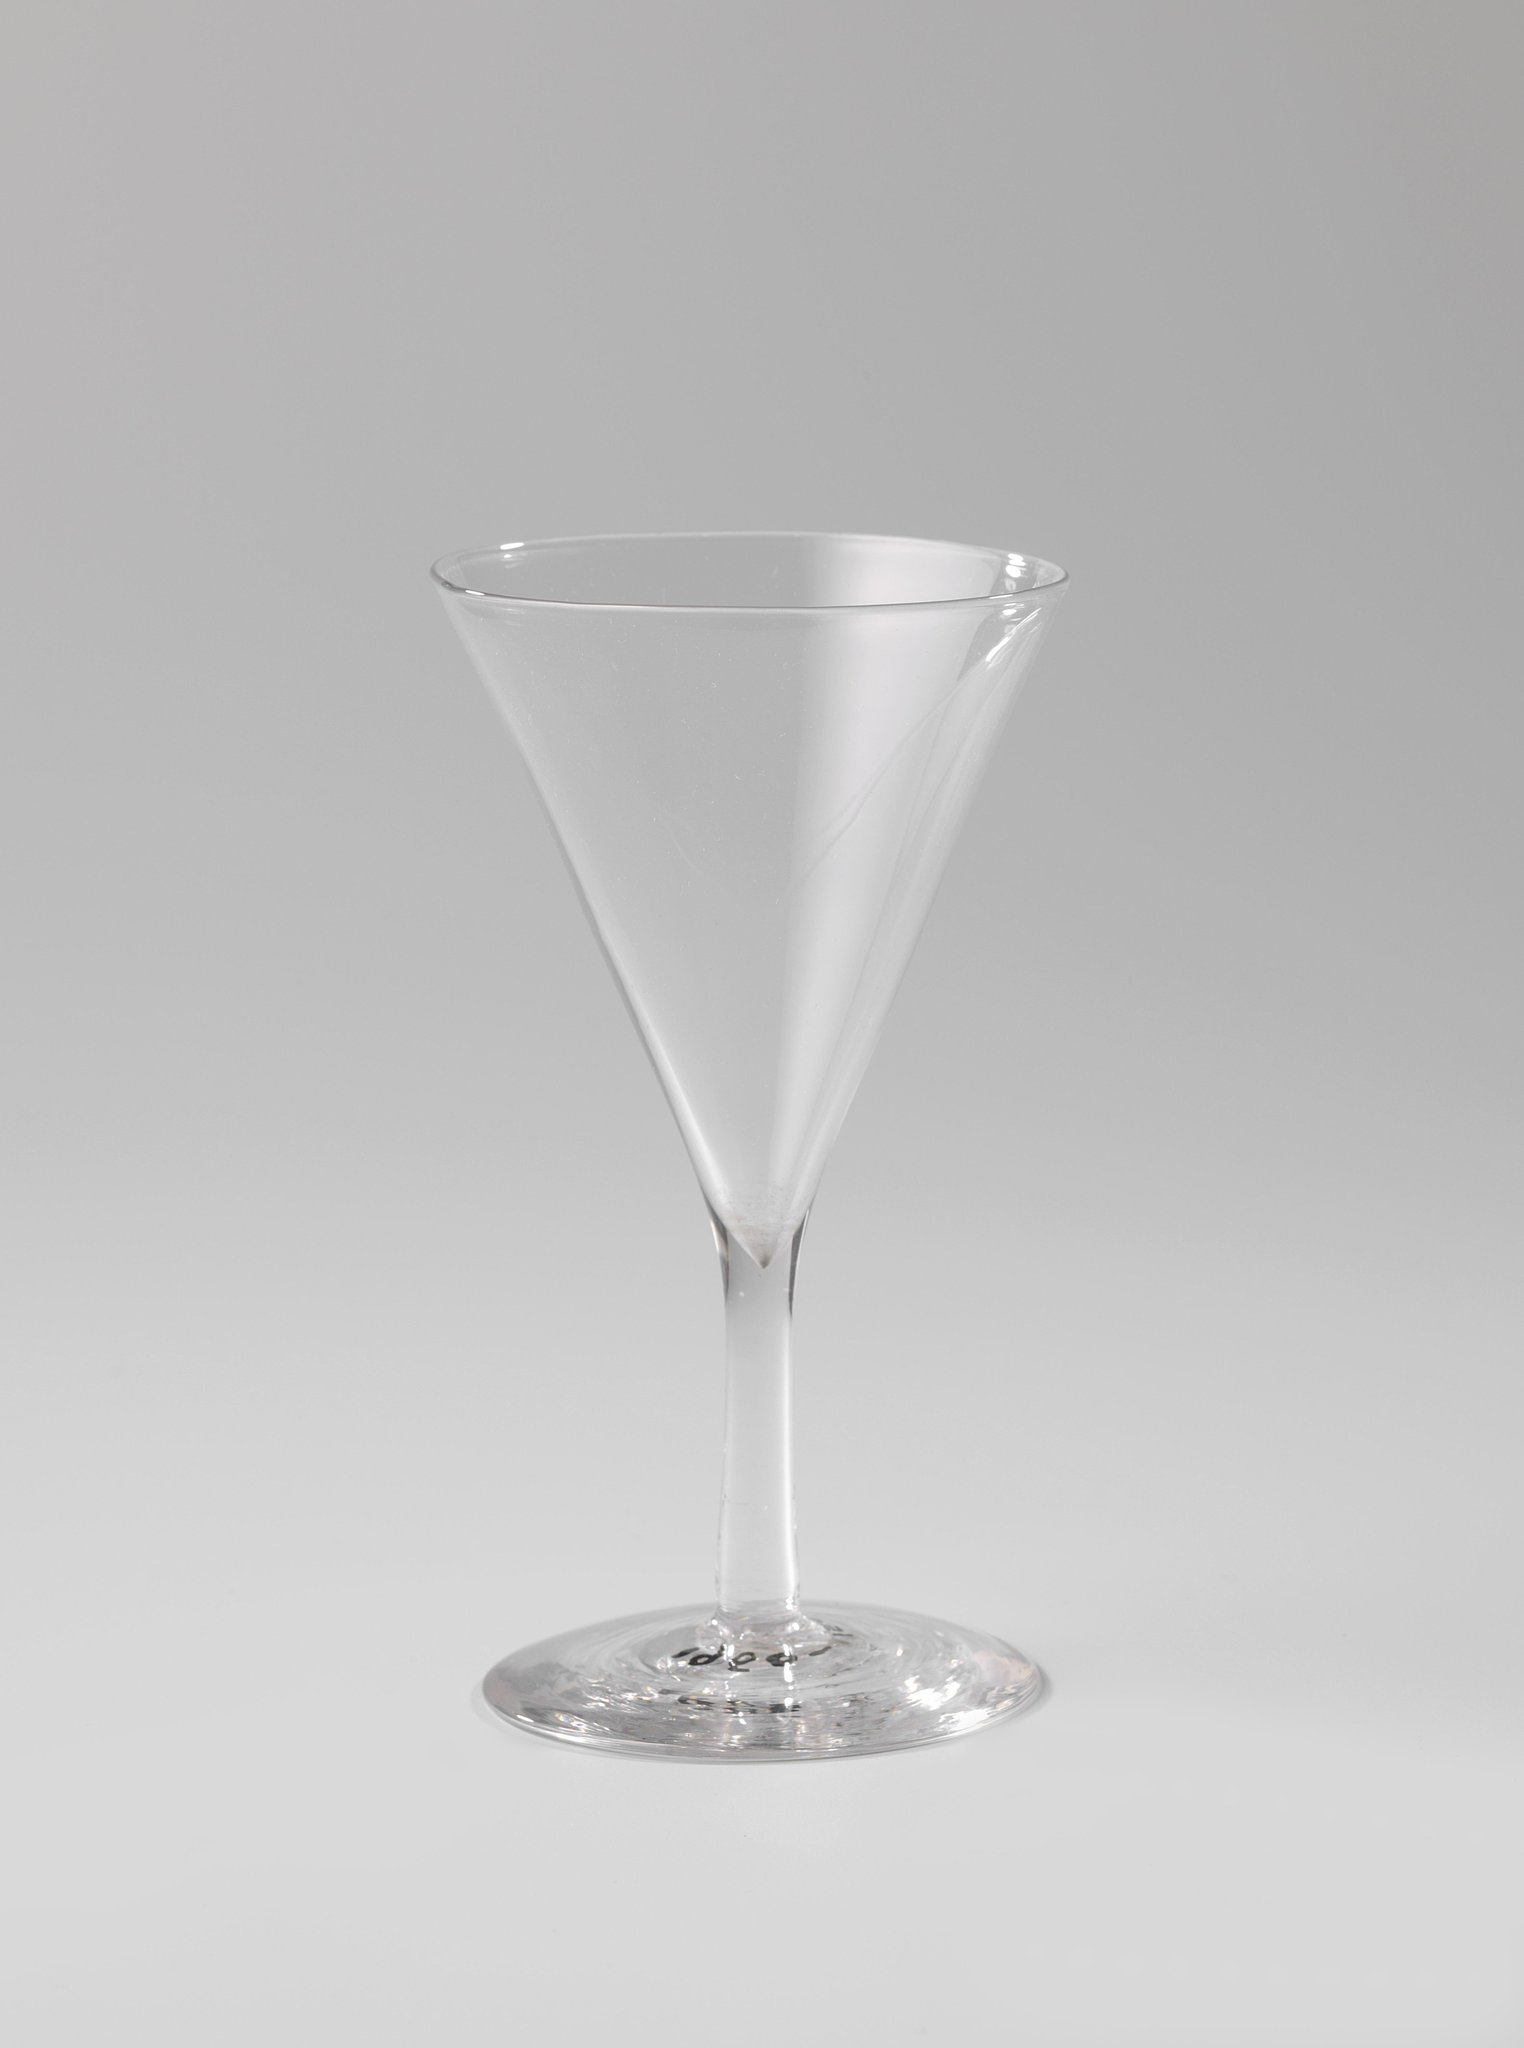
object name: goblet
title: Kelkglas, trechtervormig met onversierde cilindervormige stam en ronde voet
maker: Anonymous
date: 1800-1900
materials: glass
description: Kelkglas, trechtervormig met onversierde cilindervormige stam en ronde voet.